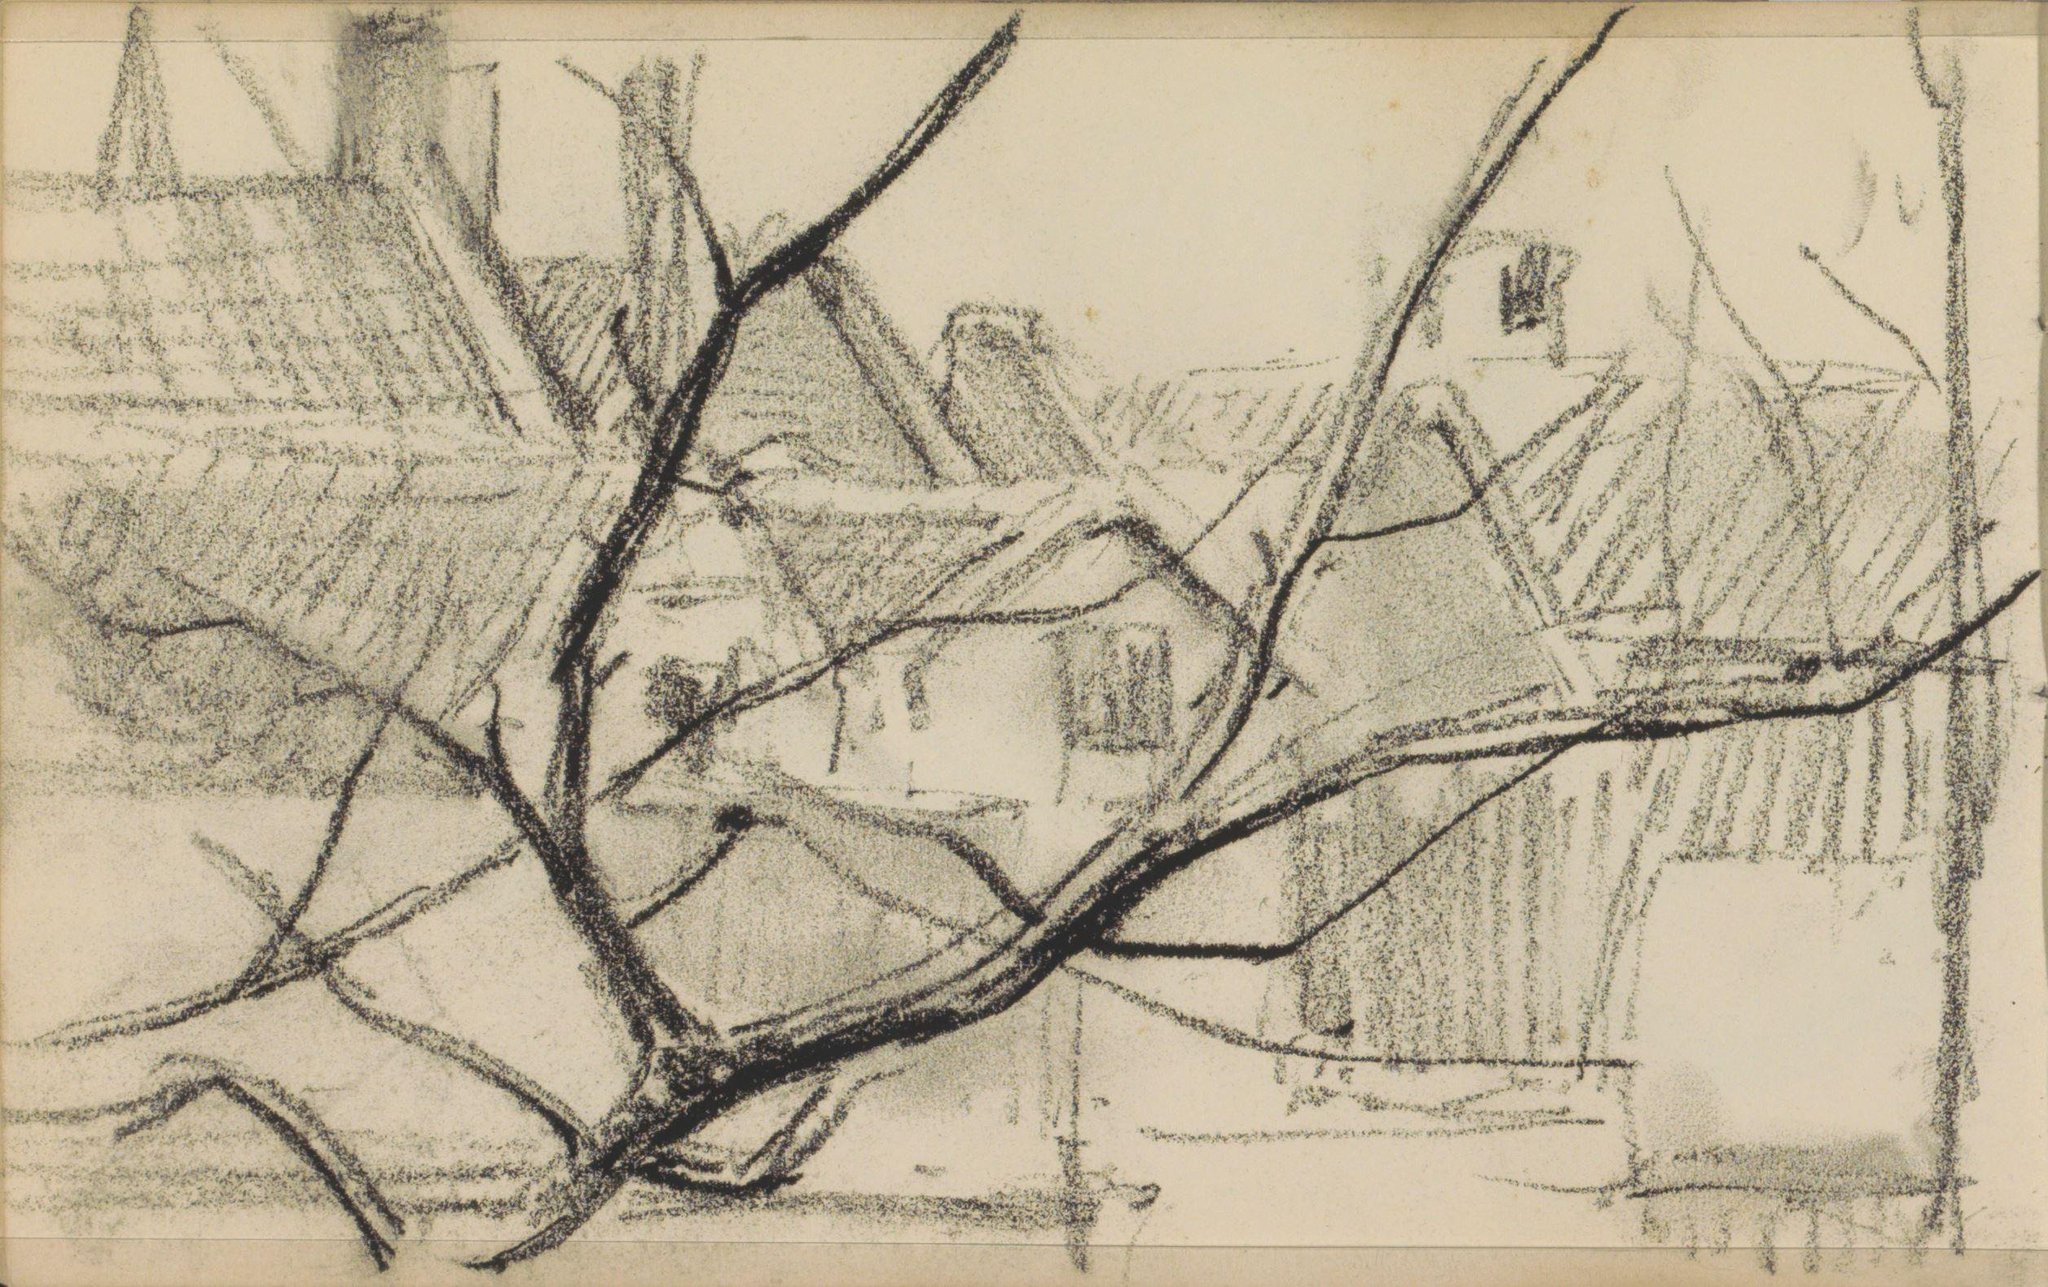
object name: sketchbook leaf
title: Gezicht op de daken van een straat door de kale takken van een boom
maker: a.a.l. de grammont-hubrecht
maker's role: draughtsman, painter, print maker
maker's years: 1855-1913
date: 1892-1913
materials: chalk, paper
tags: trees, street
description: Blad 10 verso uit een schetsboek met 31 bladen.